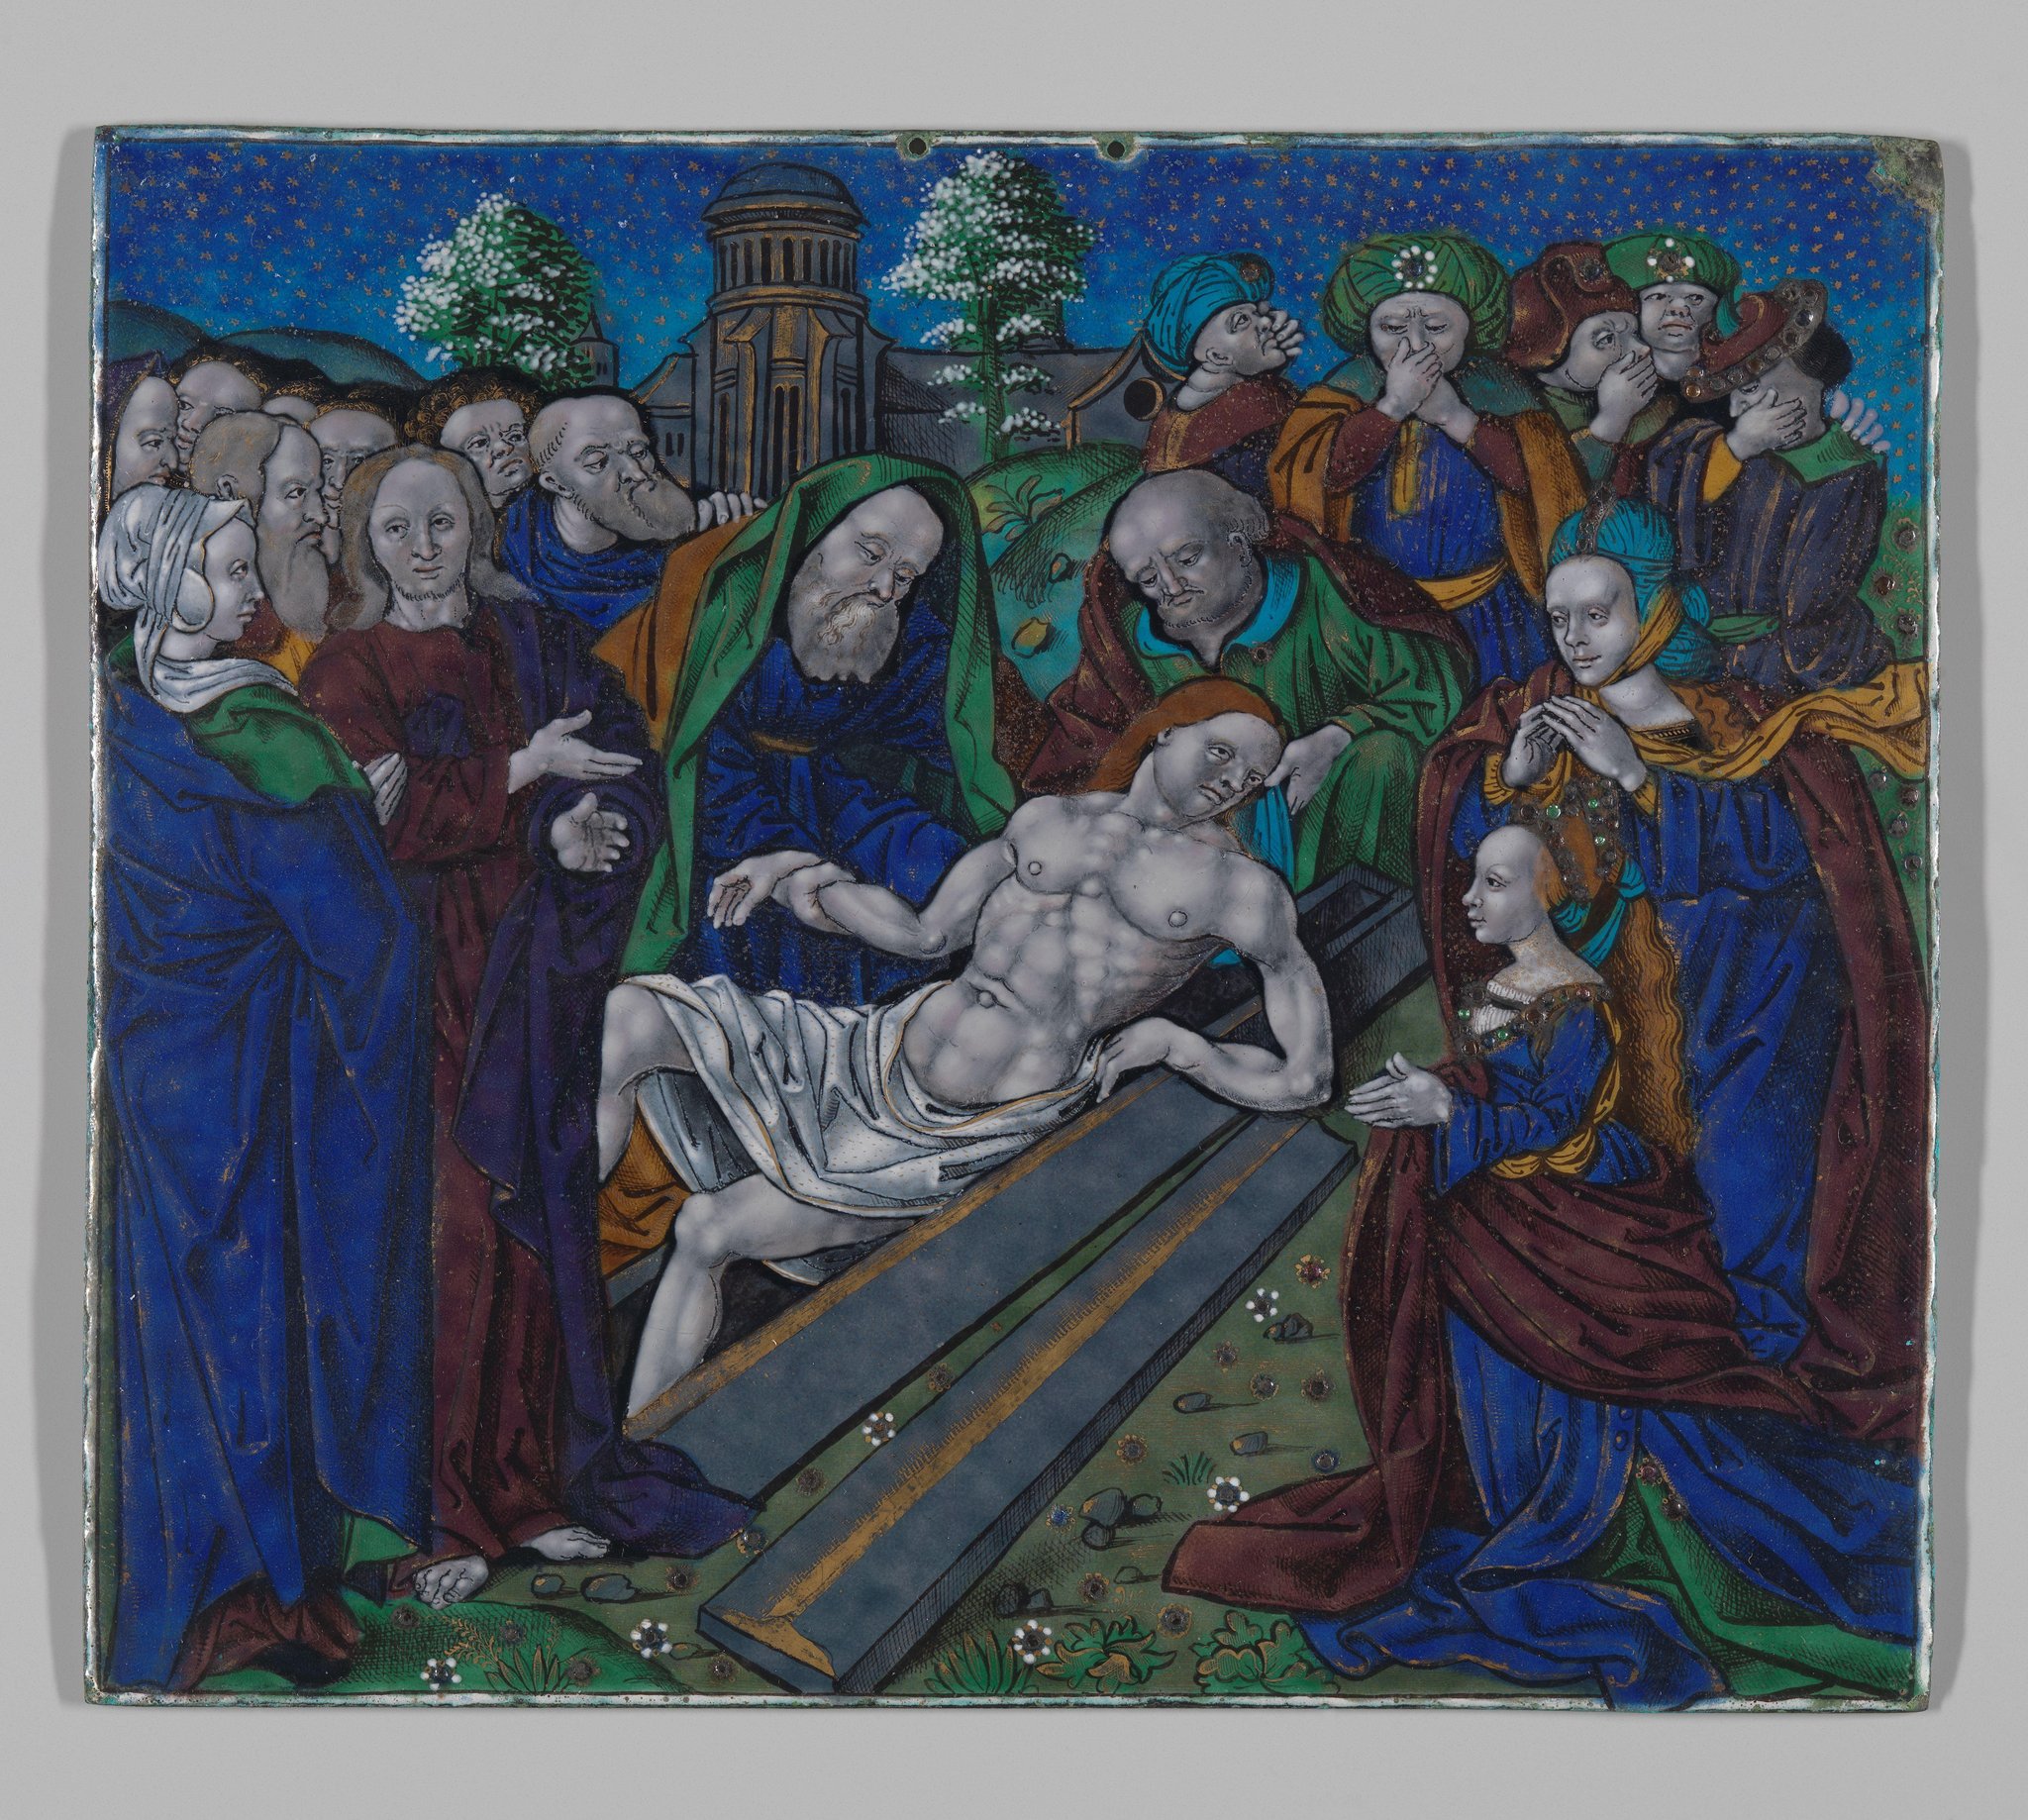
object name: plaque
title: Plaque with the Raising of Lazarus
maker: jean penicaud (i)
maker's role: jeweler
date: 1500-1525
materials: copper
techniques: enameling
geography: limoges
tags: the raising of lazarus ('lazarus, come out')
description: Enamel is a mixture of molten glass that is applied to a metal support. Here the copper plate is provided with a layer of silver, which heightens the luminosity of the translucent enamel colour. Lazarus was brought back to life by Christ four days after his death. The onlookers hold their noses against the 0smell of his decomposing body.